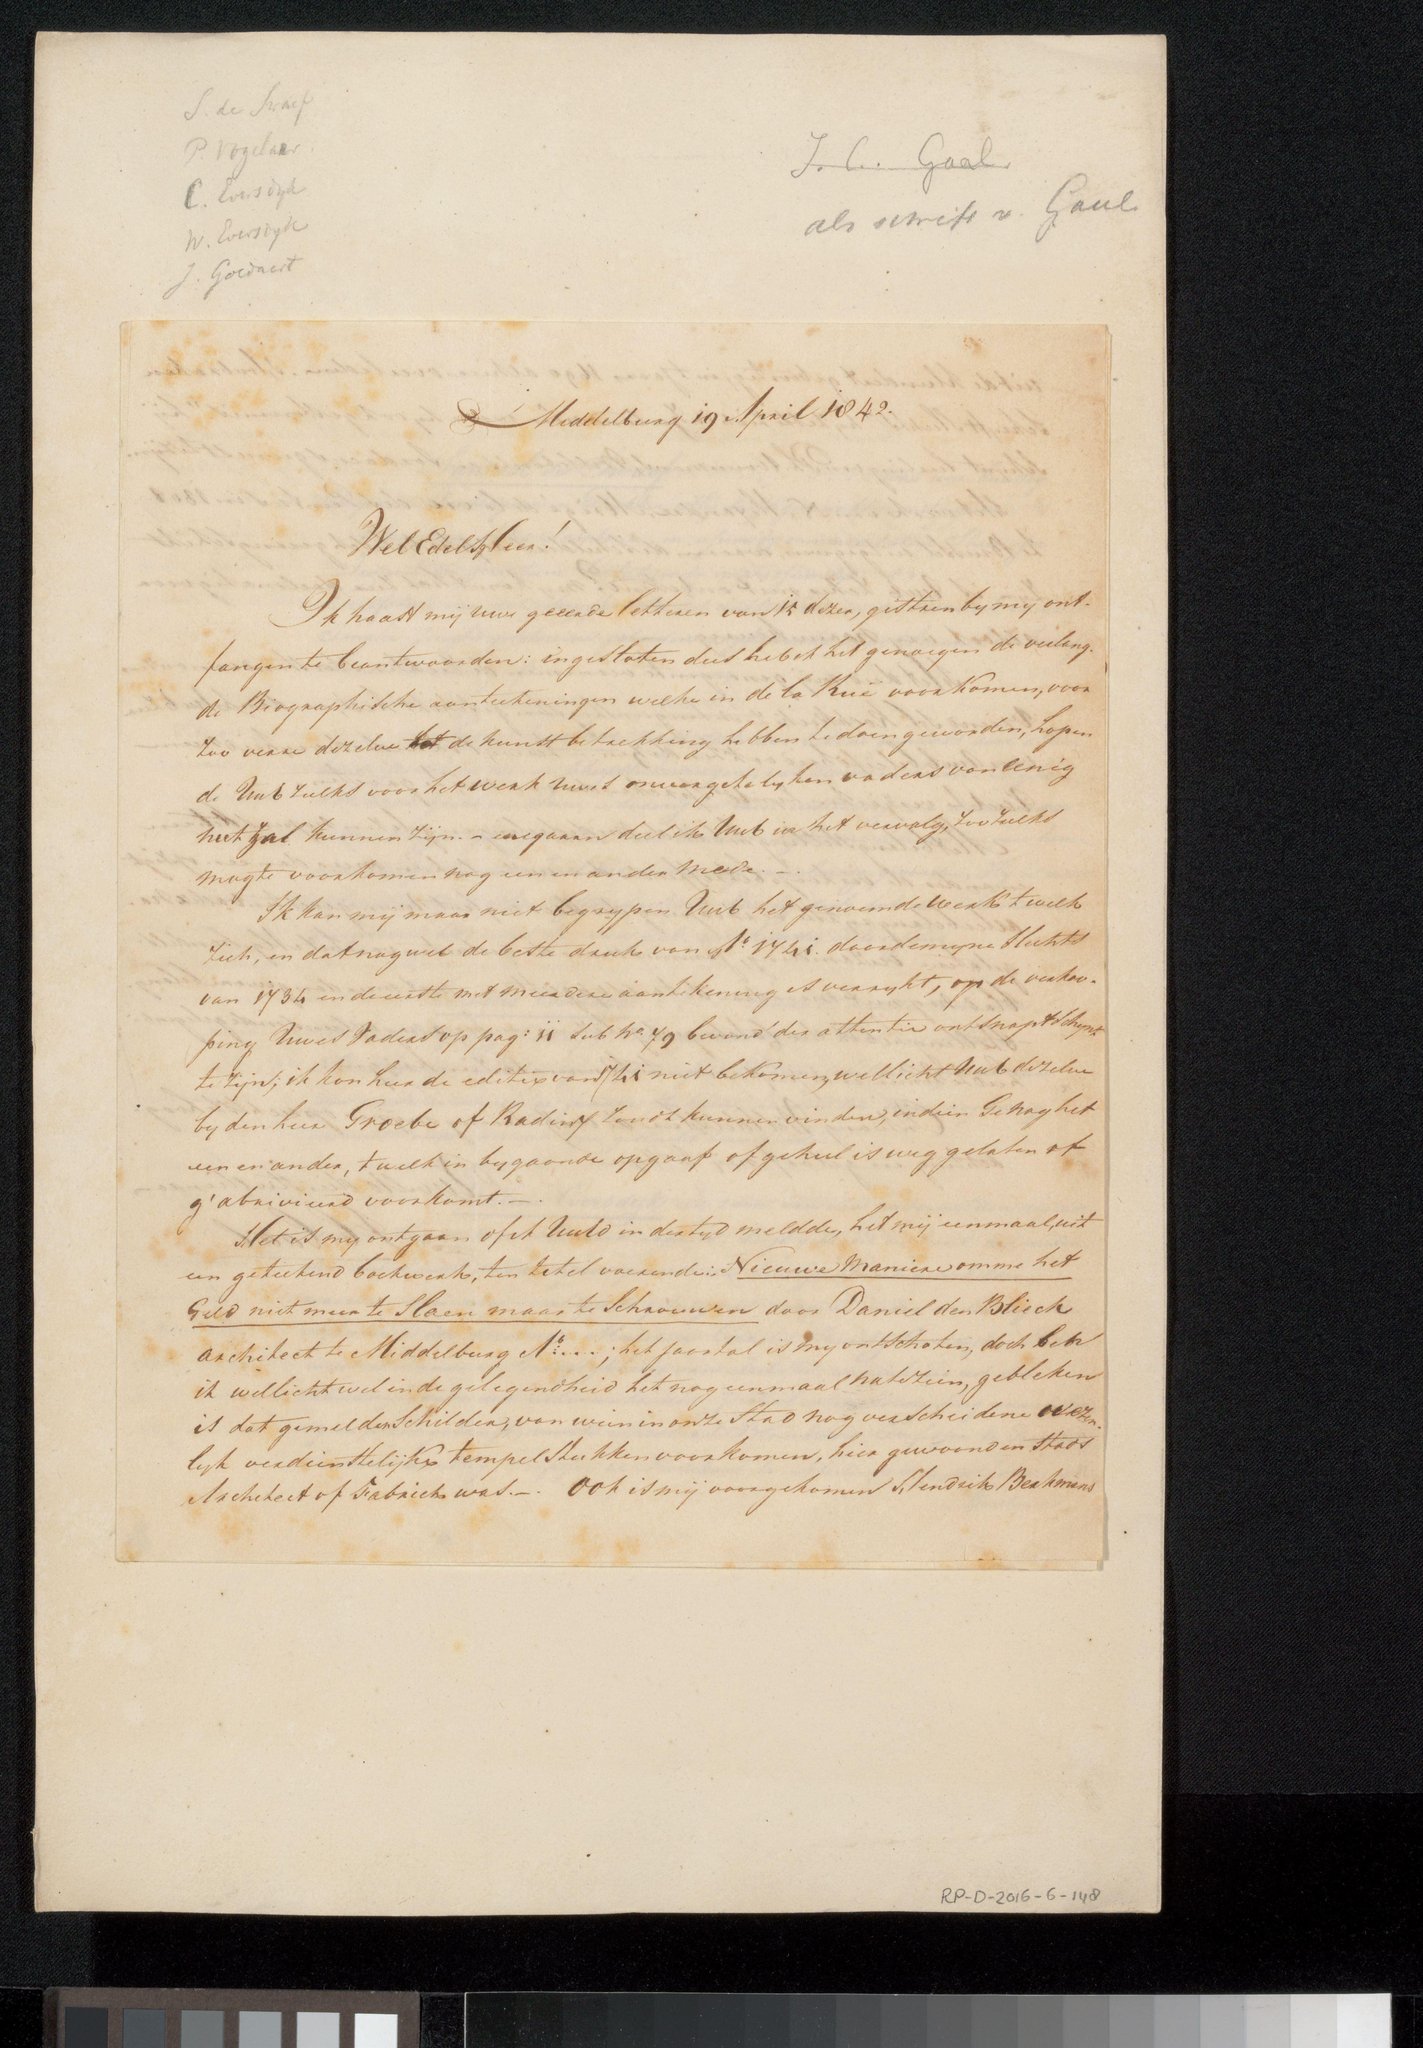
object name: letter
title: Brief aan Johannes Immerzeel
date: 1842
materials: ink, paper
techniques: pen, writing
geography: middelburg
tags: jacobus cornelis gaal, pieter vogelaer, painter, willem eversdijck, samuel de swaef, middelburg, print maker, draughtsman, johannes goedaert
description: Opgenomen in: Immerzeel, J. Jr., De levens en werken der Hollandsche en Vlaamsche kunstschilders, beeldhouwers, graveurs en bouwmeesters, van het begin der vijftiende eeuw tot heden, Amsterdam: J.C. van Kesteren, 1842-1843.